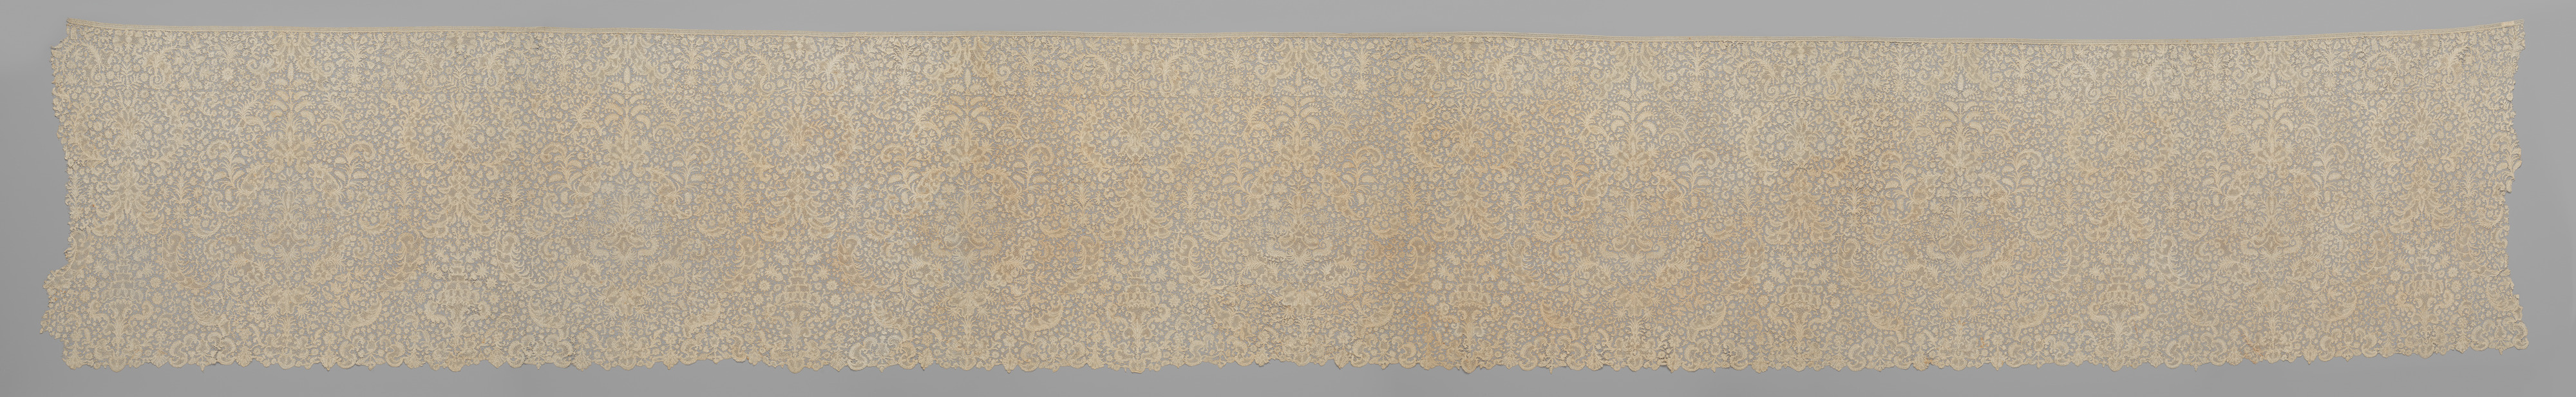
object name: flounce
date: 1601-1800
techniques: lace